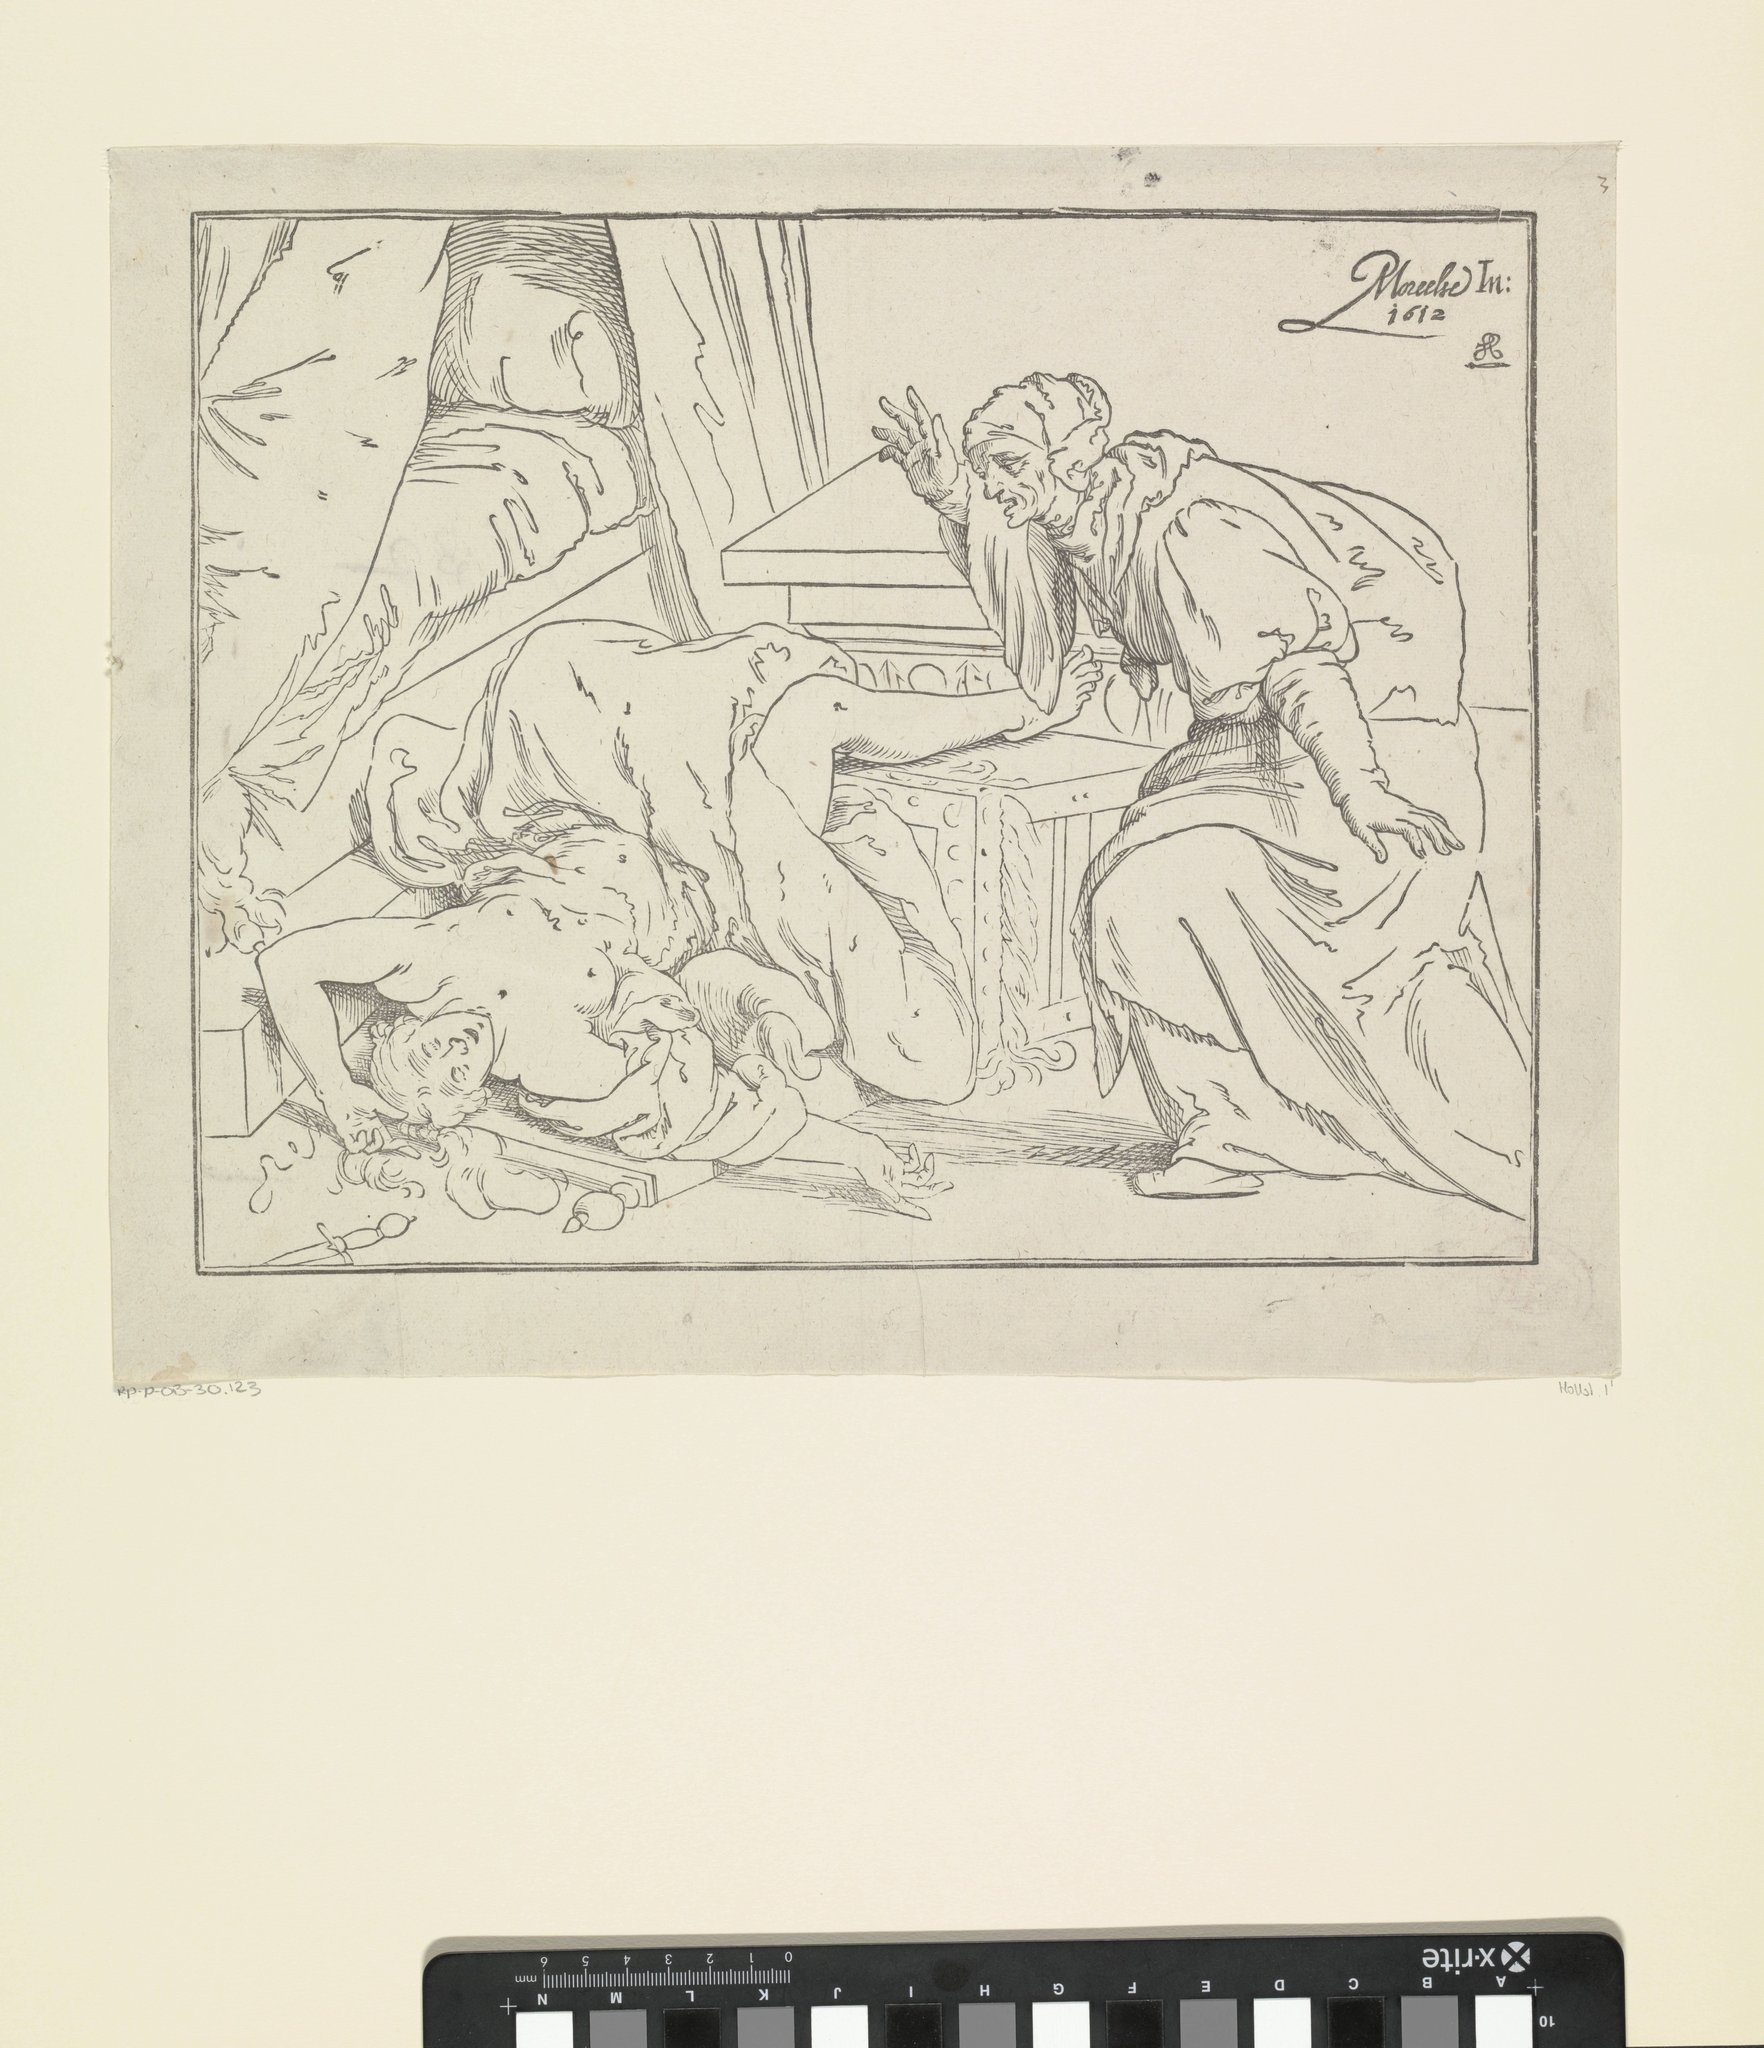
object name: print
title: Dood van Lucretia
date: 1612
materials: paper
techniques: woodcut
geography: netherlands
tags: death of lucretia: she commits suicide by stabbing herself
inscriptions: collector's mark: Lugt 240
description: Lucretia pleegt zelfmoord door zich met een dolk te doorsteken, omdat ze de schaamte na de verkrachting door Sextus niet meer aan kan. Haar naakte lichaam ligt op de grond naast haar bed. Haar man Collatinus rent op haar af.